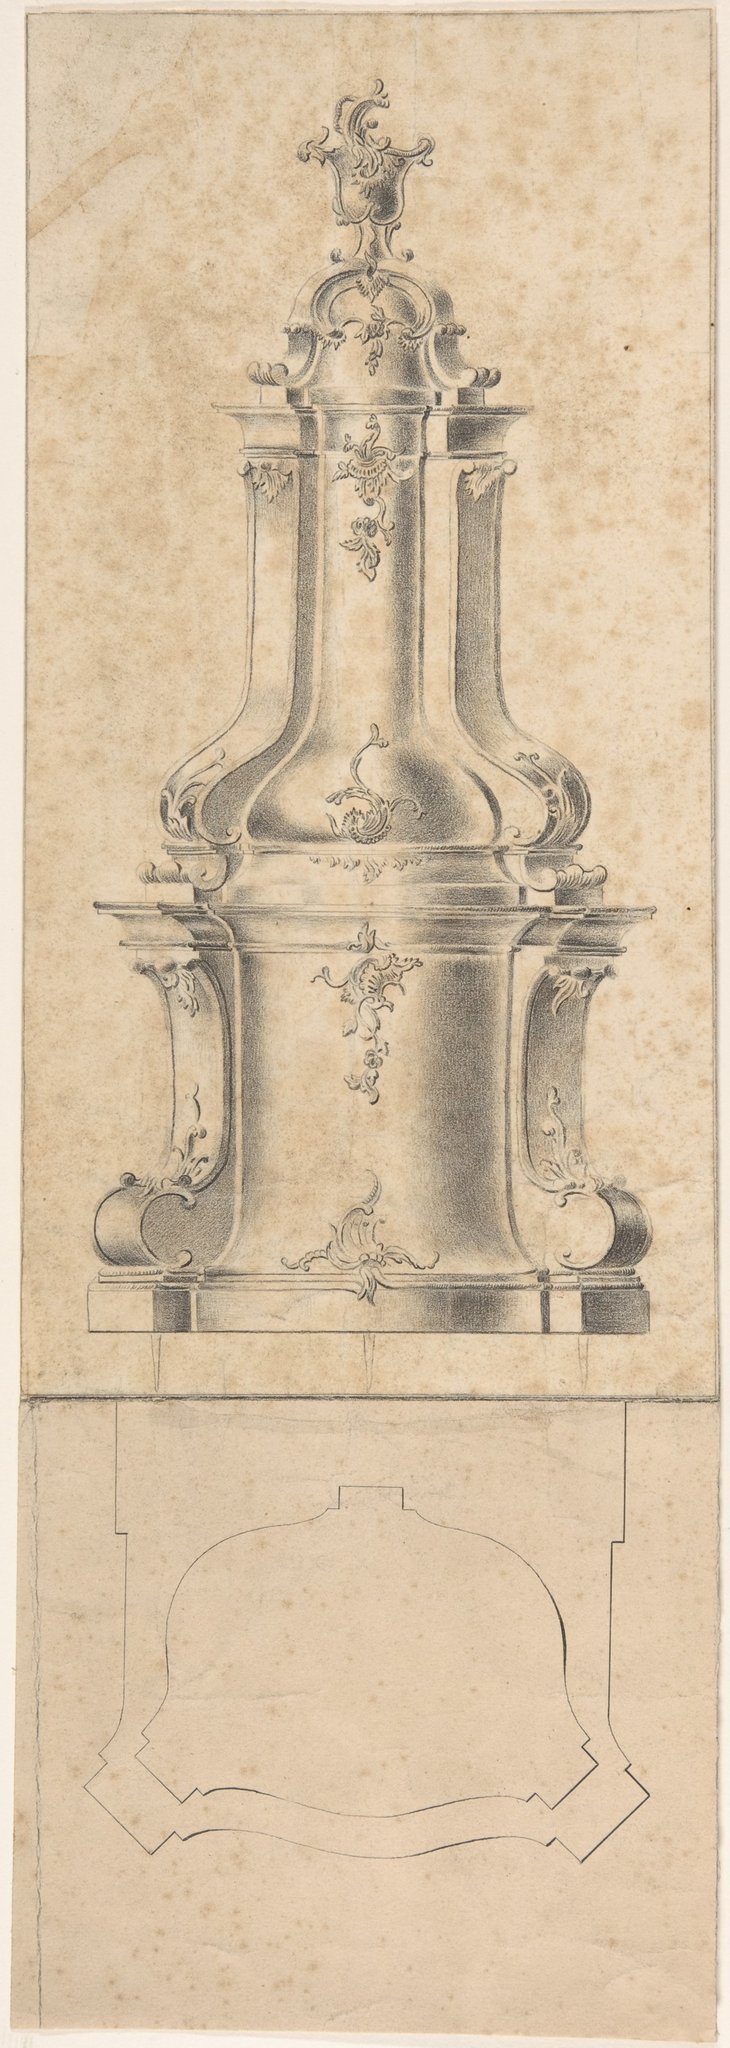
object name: drawing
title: Designs for a Stove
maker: anonymous, german, 18th century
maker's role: artist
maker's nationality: german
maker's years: 1700-1800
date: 1701-1800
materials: chalk, ink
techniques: drawing, pen